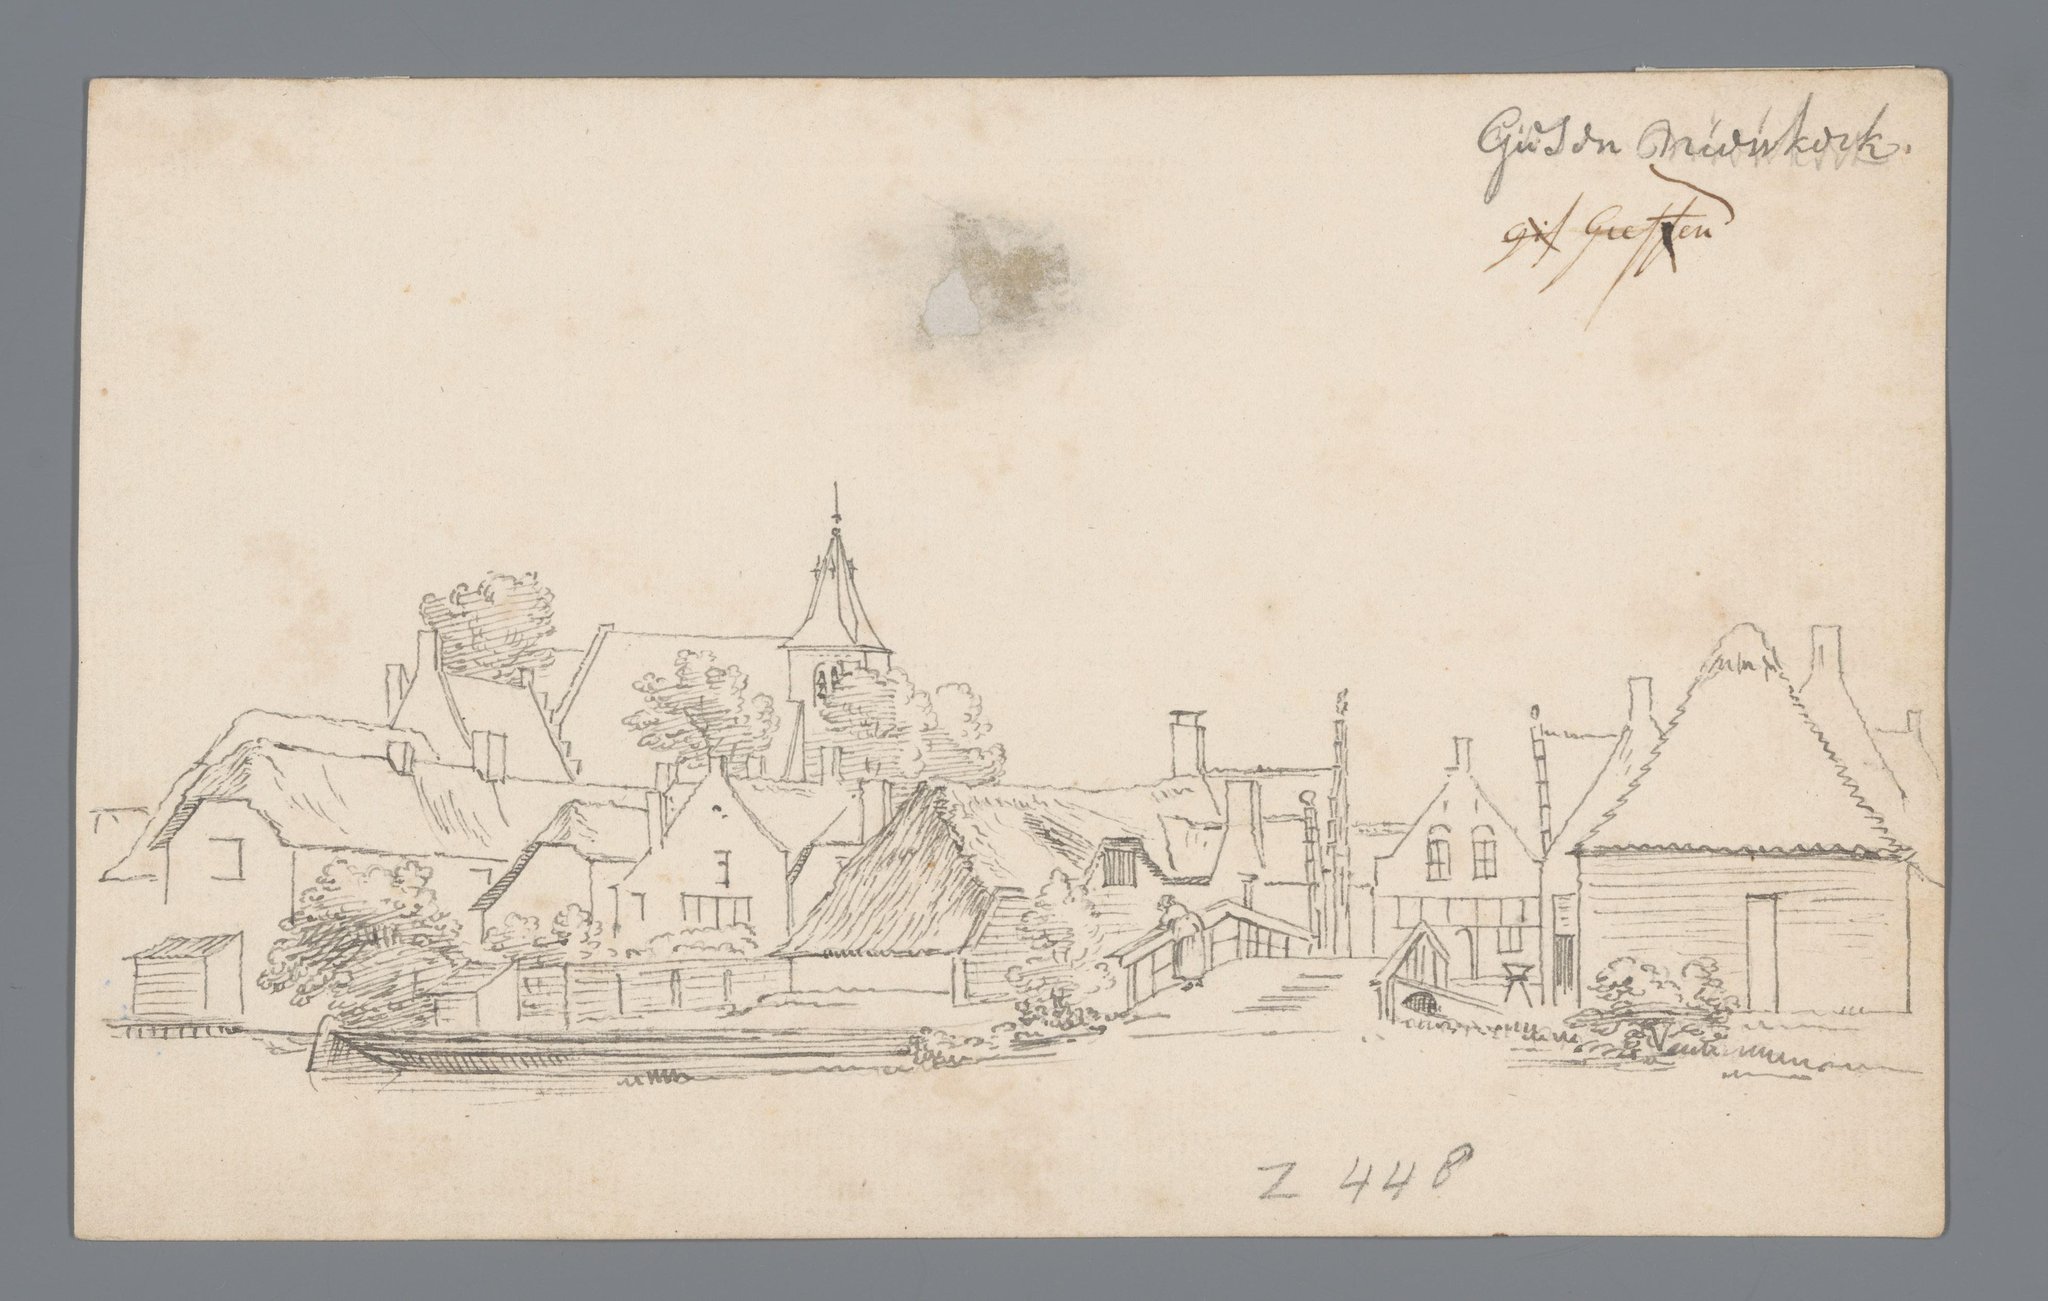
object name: drawing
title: Giessen Nieuwkerk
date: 1730-1780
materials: ink, paper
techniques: pen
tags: village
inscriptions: collector's mark: Lugt 2228, inscription: ‘Giessen Nieuwkerk’